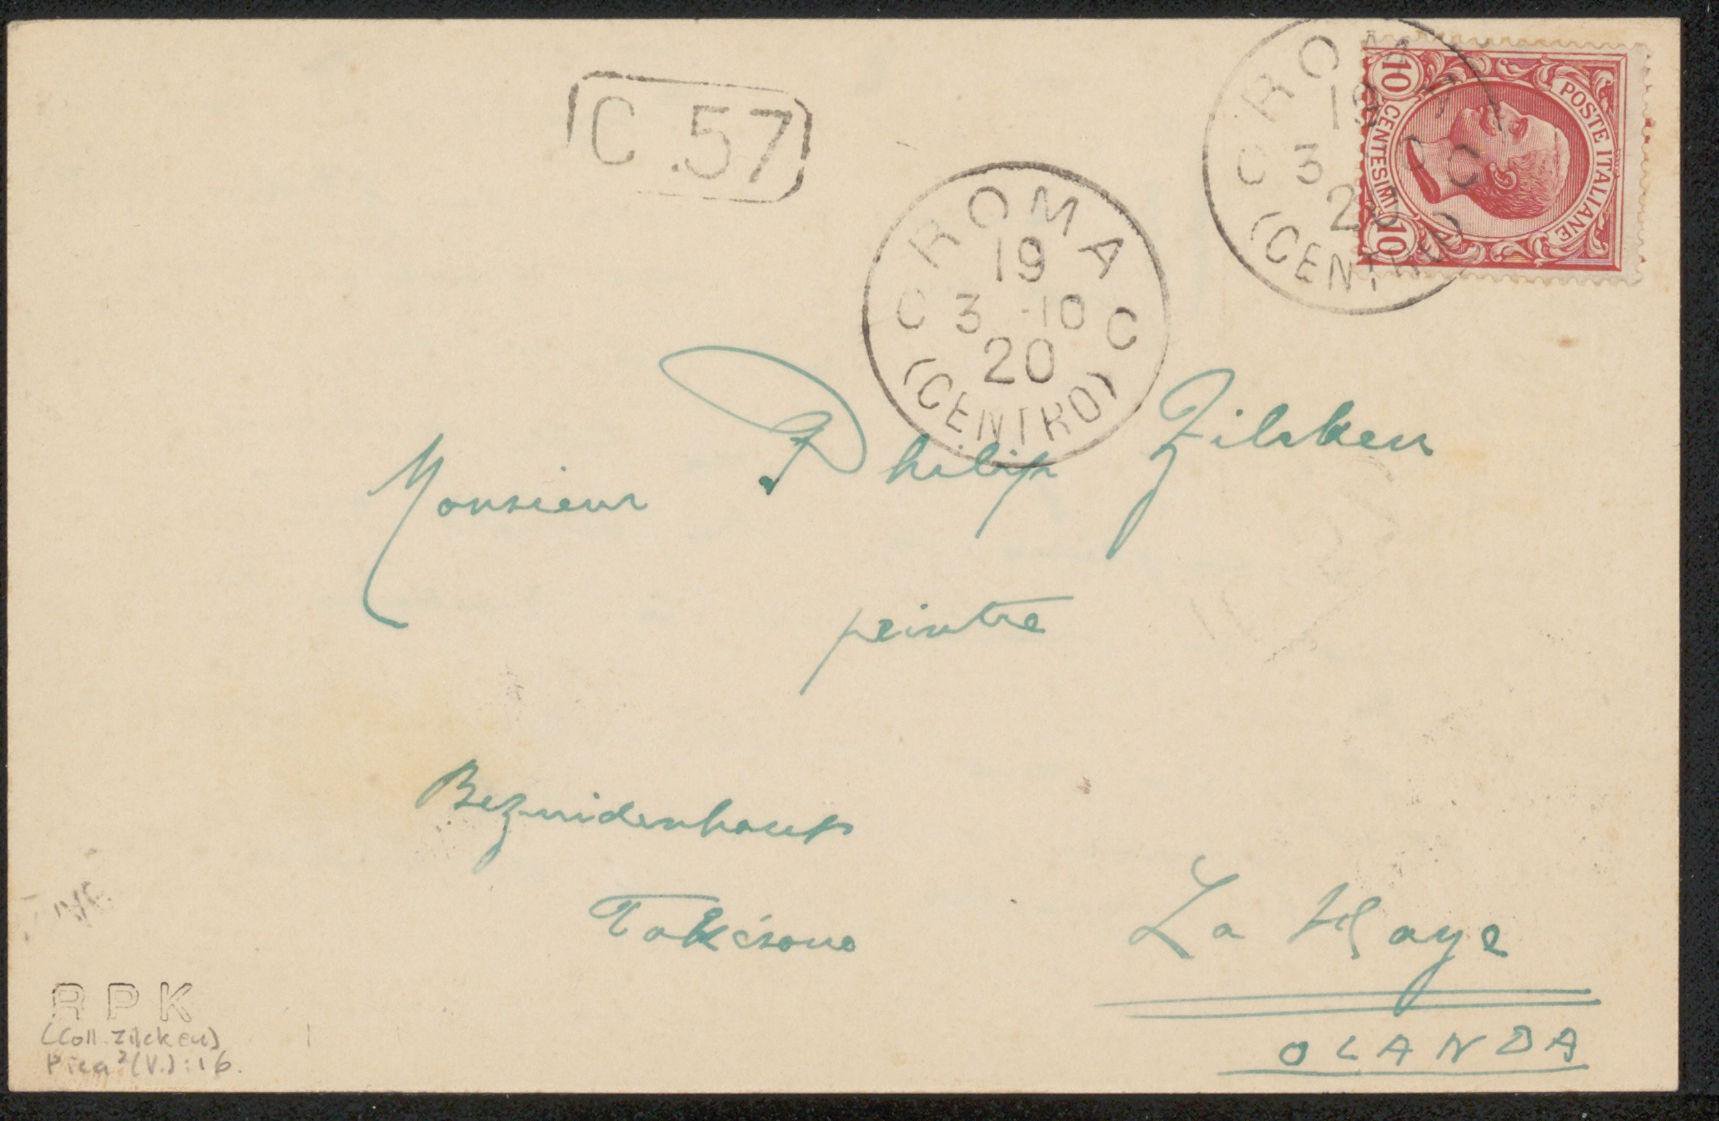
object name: letter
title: Brief aan Philip Zilcken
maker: vittorio pica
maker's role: criticus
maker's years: 1864-1930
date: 1910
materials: cardboard, ink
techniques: pen, printing, writing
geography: rome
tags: print maker, jozef israëls, the hague, painter, draughtsman, philip zilcken, anonymous historical person portrayed, printed matter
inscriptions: collector's mark: ‘RPK’